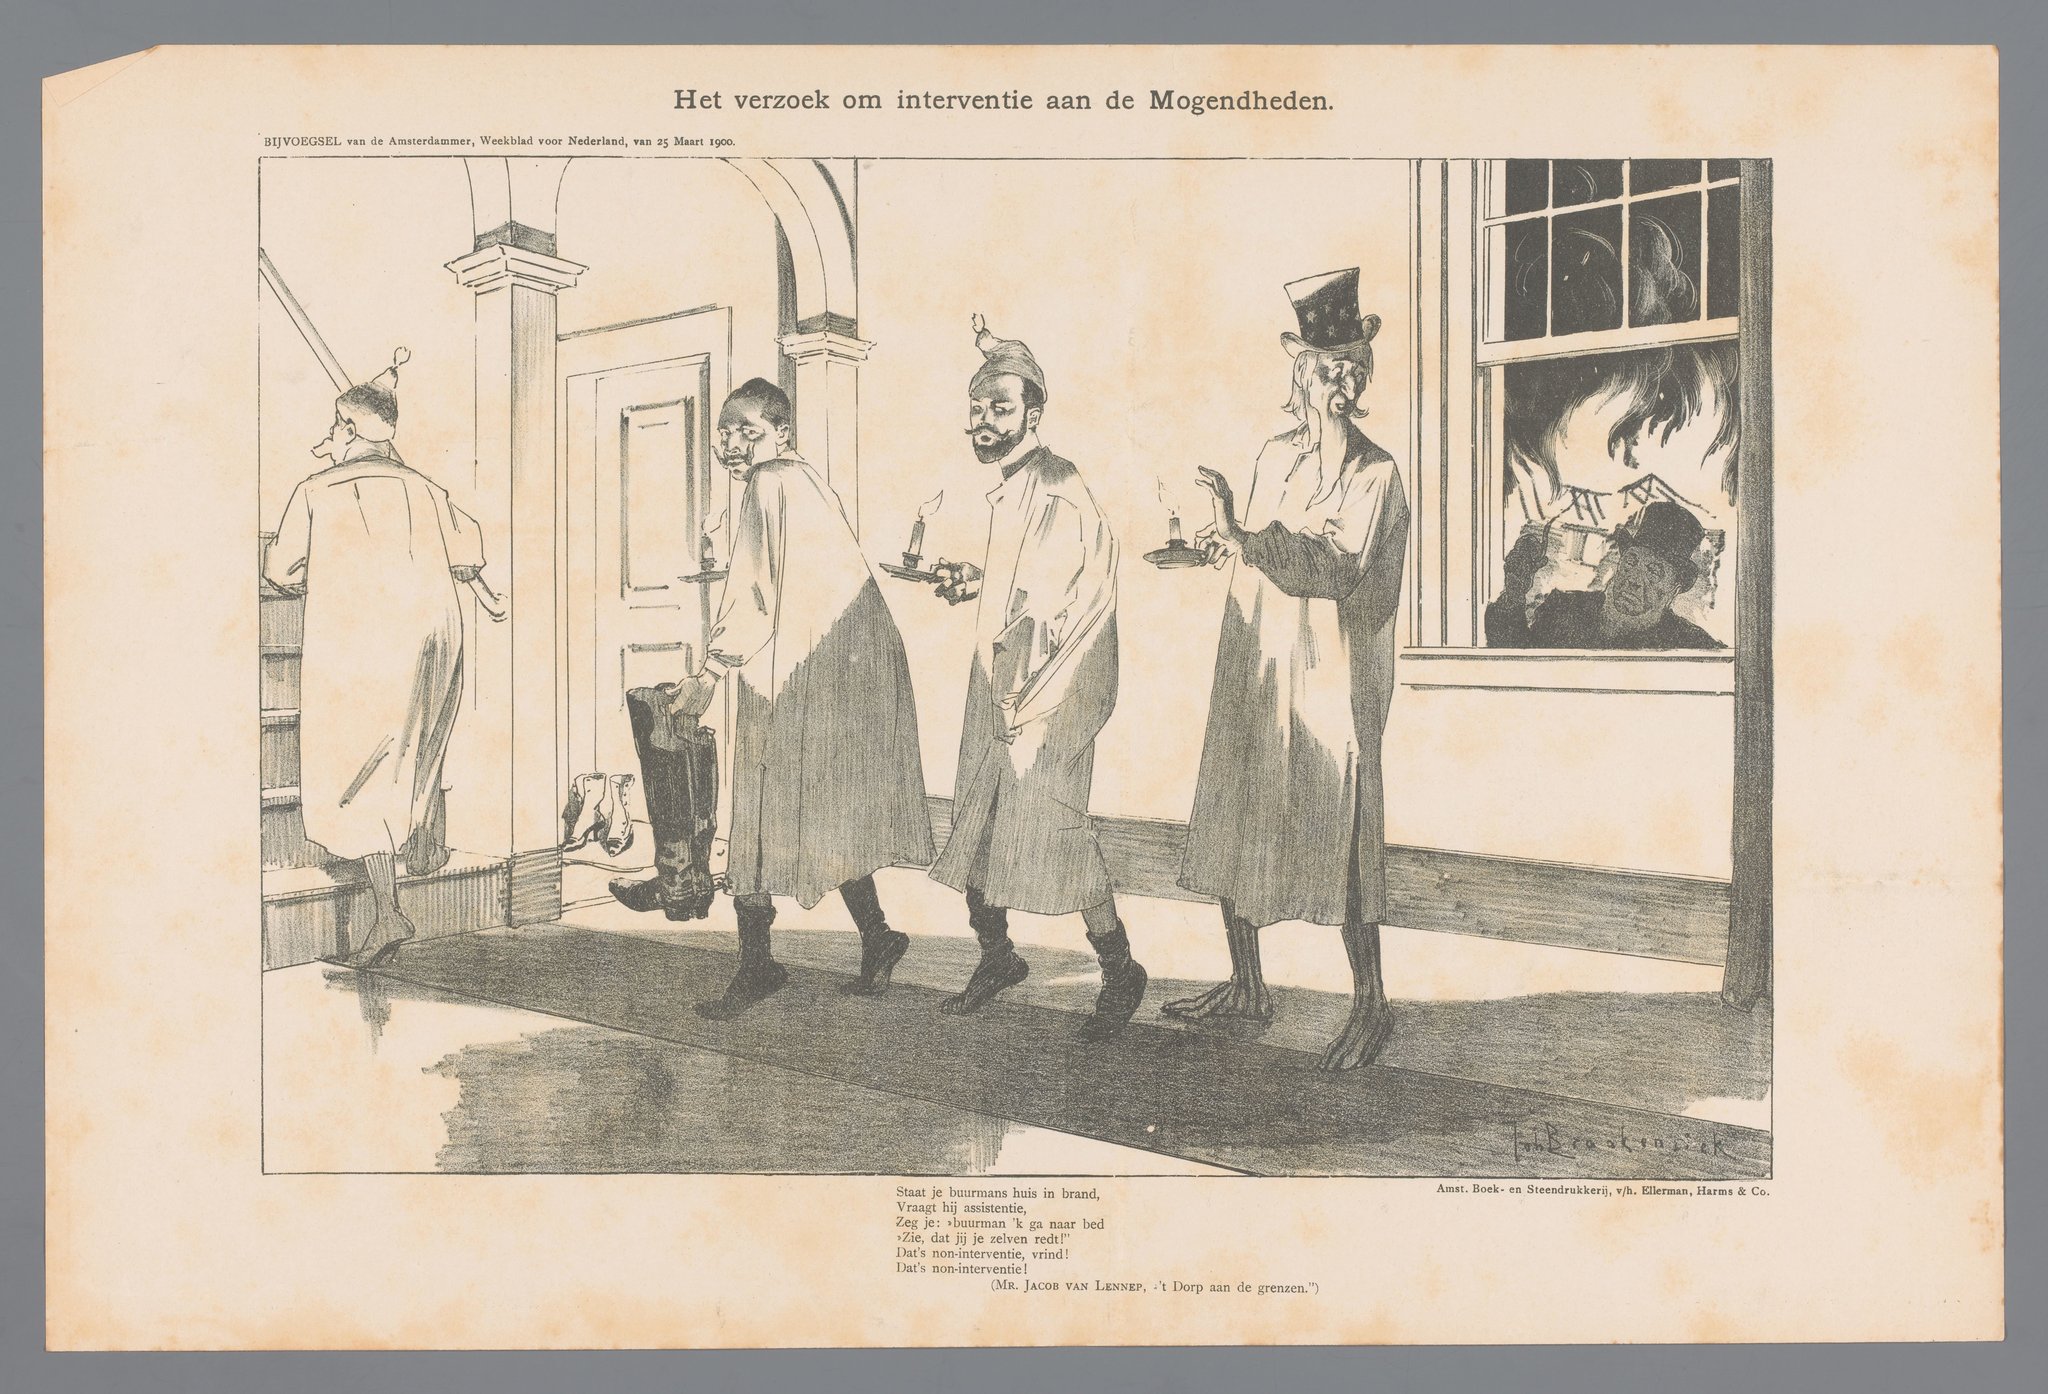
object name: cartoon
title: Het verzoek om interventie aan de Mogendheden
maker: johan braakensiek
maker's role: draughtsman, print maker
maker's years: 1858-1940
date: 1900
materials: paper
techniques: lithograph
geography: amsterdam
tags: wilhelm ii (keizer van duitsland), personifications of countries, nations, states, districts, etc., historical persons, ruler, sovereign, political caricatures and satires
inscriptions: date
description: Prent uit het bijvoegsel van: De Amsterdammer. Weekblad voor Nederland, 25 maart 1900.